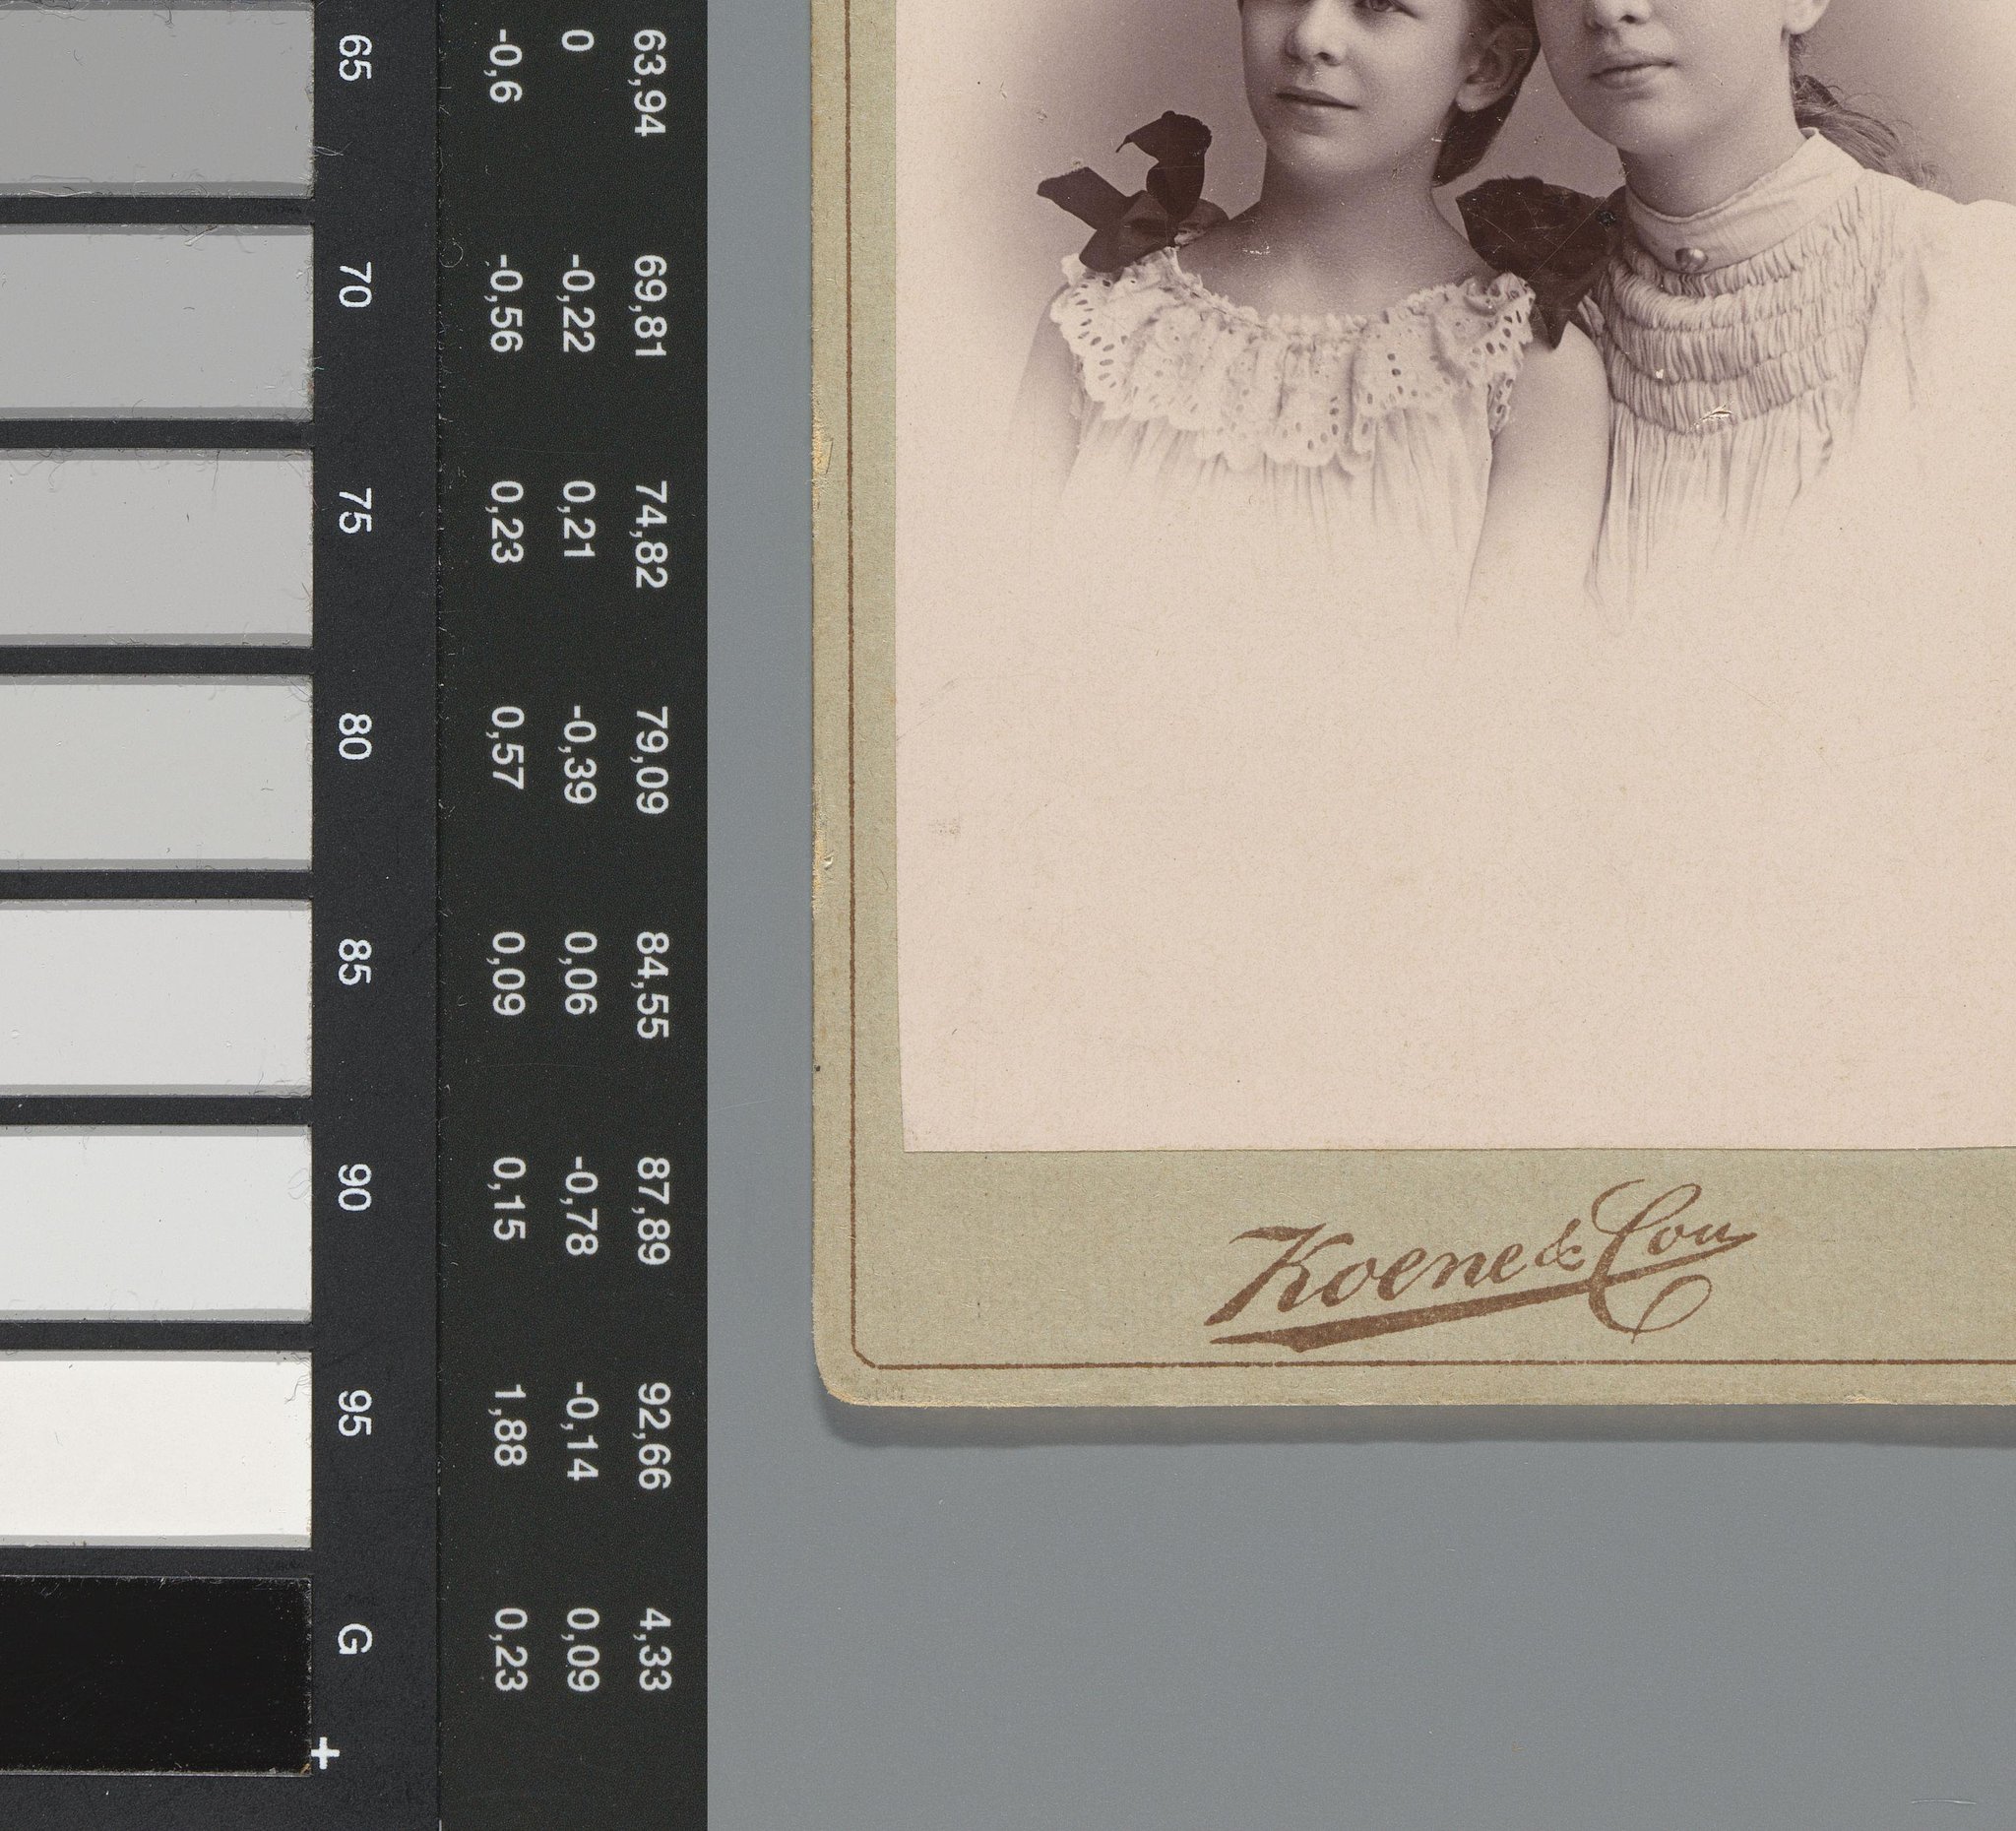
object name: carte de visite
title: Portret van twee meisjes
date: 1892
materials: cardboard, photographic support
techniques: albumen print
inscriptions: name: ‘Koene & Co’, inscription: ‘Leo 14 ans / ... 10 ans / ... 1892’, name: ‘BATAVIA / KOENE & CO / AMSTERDAM / ALKMAAR.’